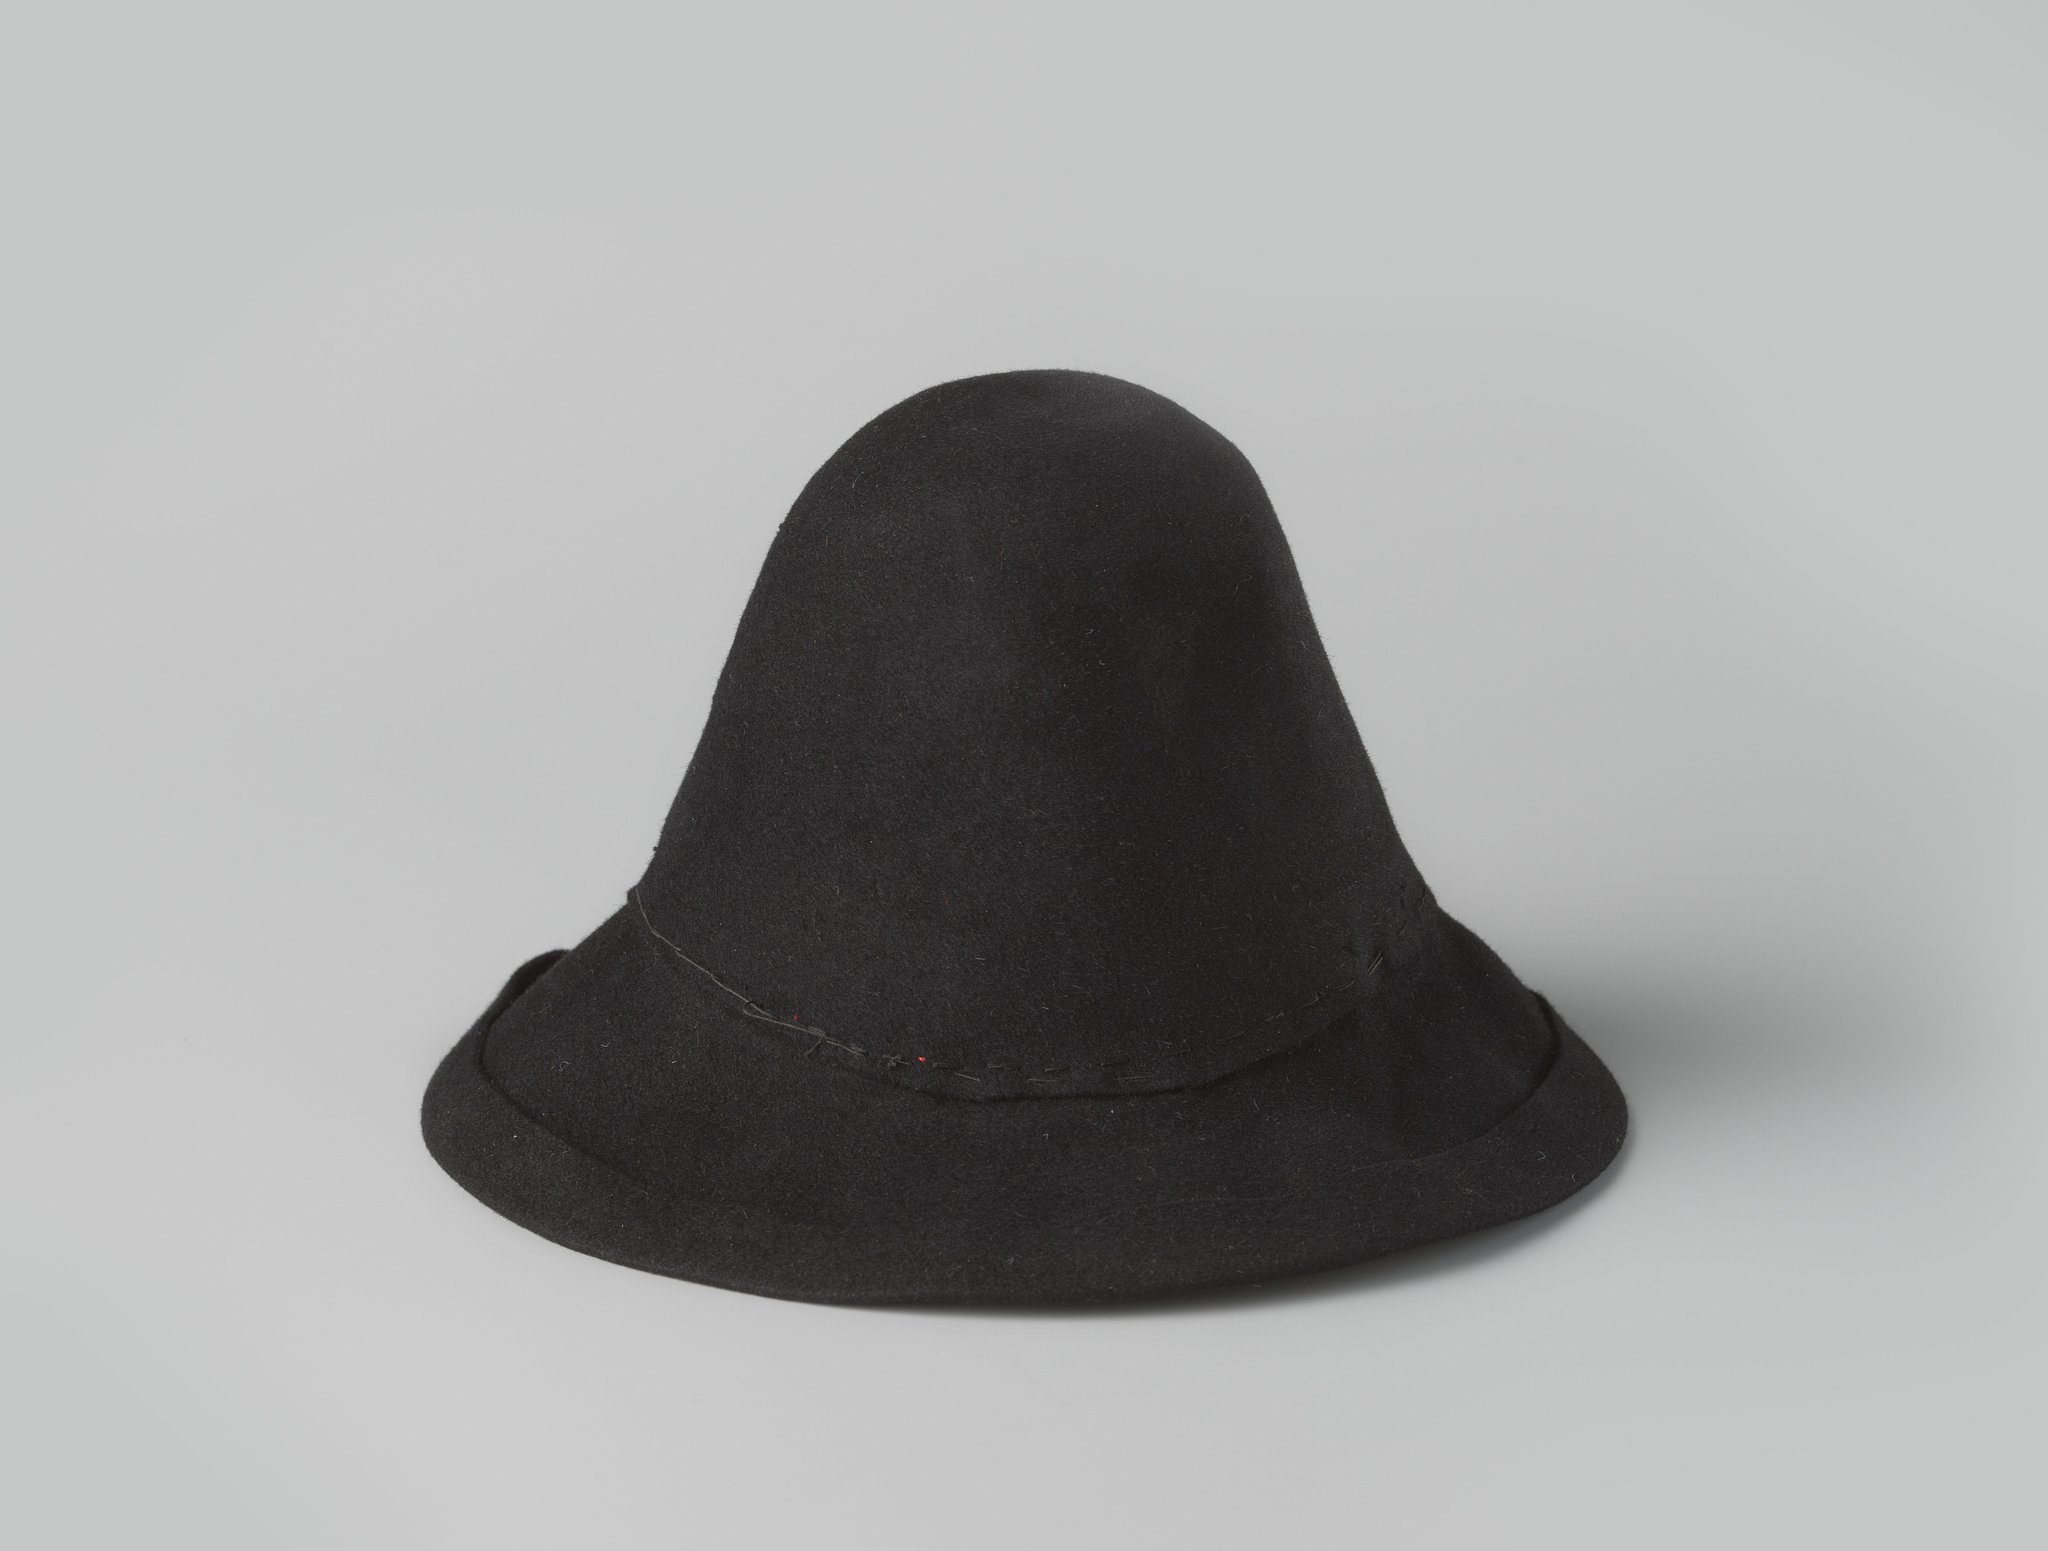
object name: hat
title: Hoed van zwart vilt met hoge bol en afhangende rand, klein model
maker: rose valois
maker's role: modiste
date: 1938-1940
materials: felt, yarns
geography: france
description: Hoed van zwart vilt met hoge bol en afhangende rand, klein model.